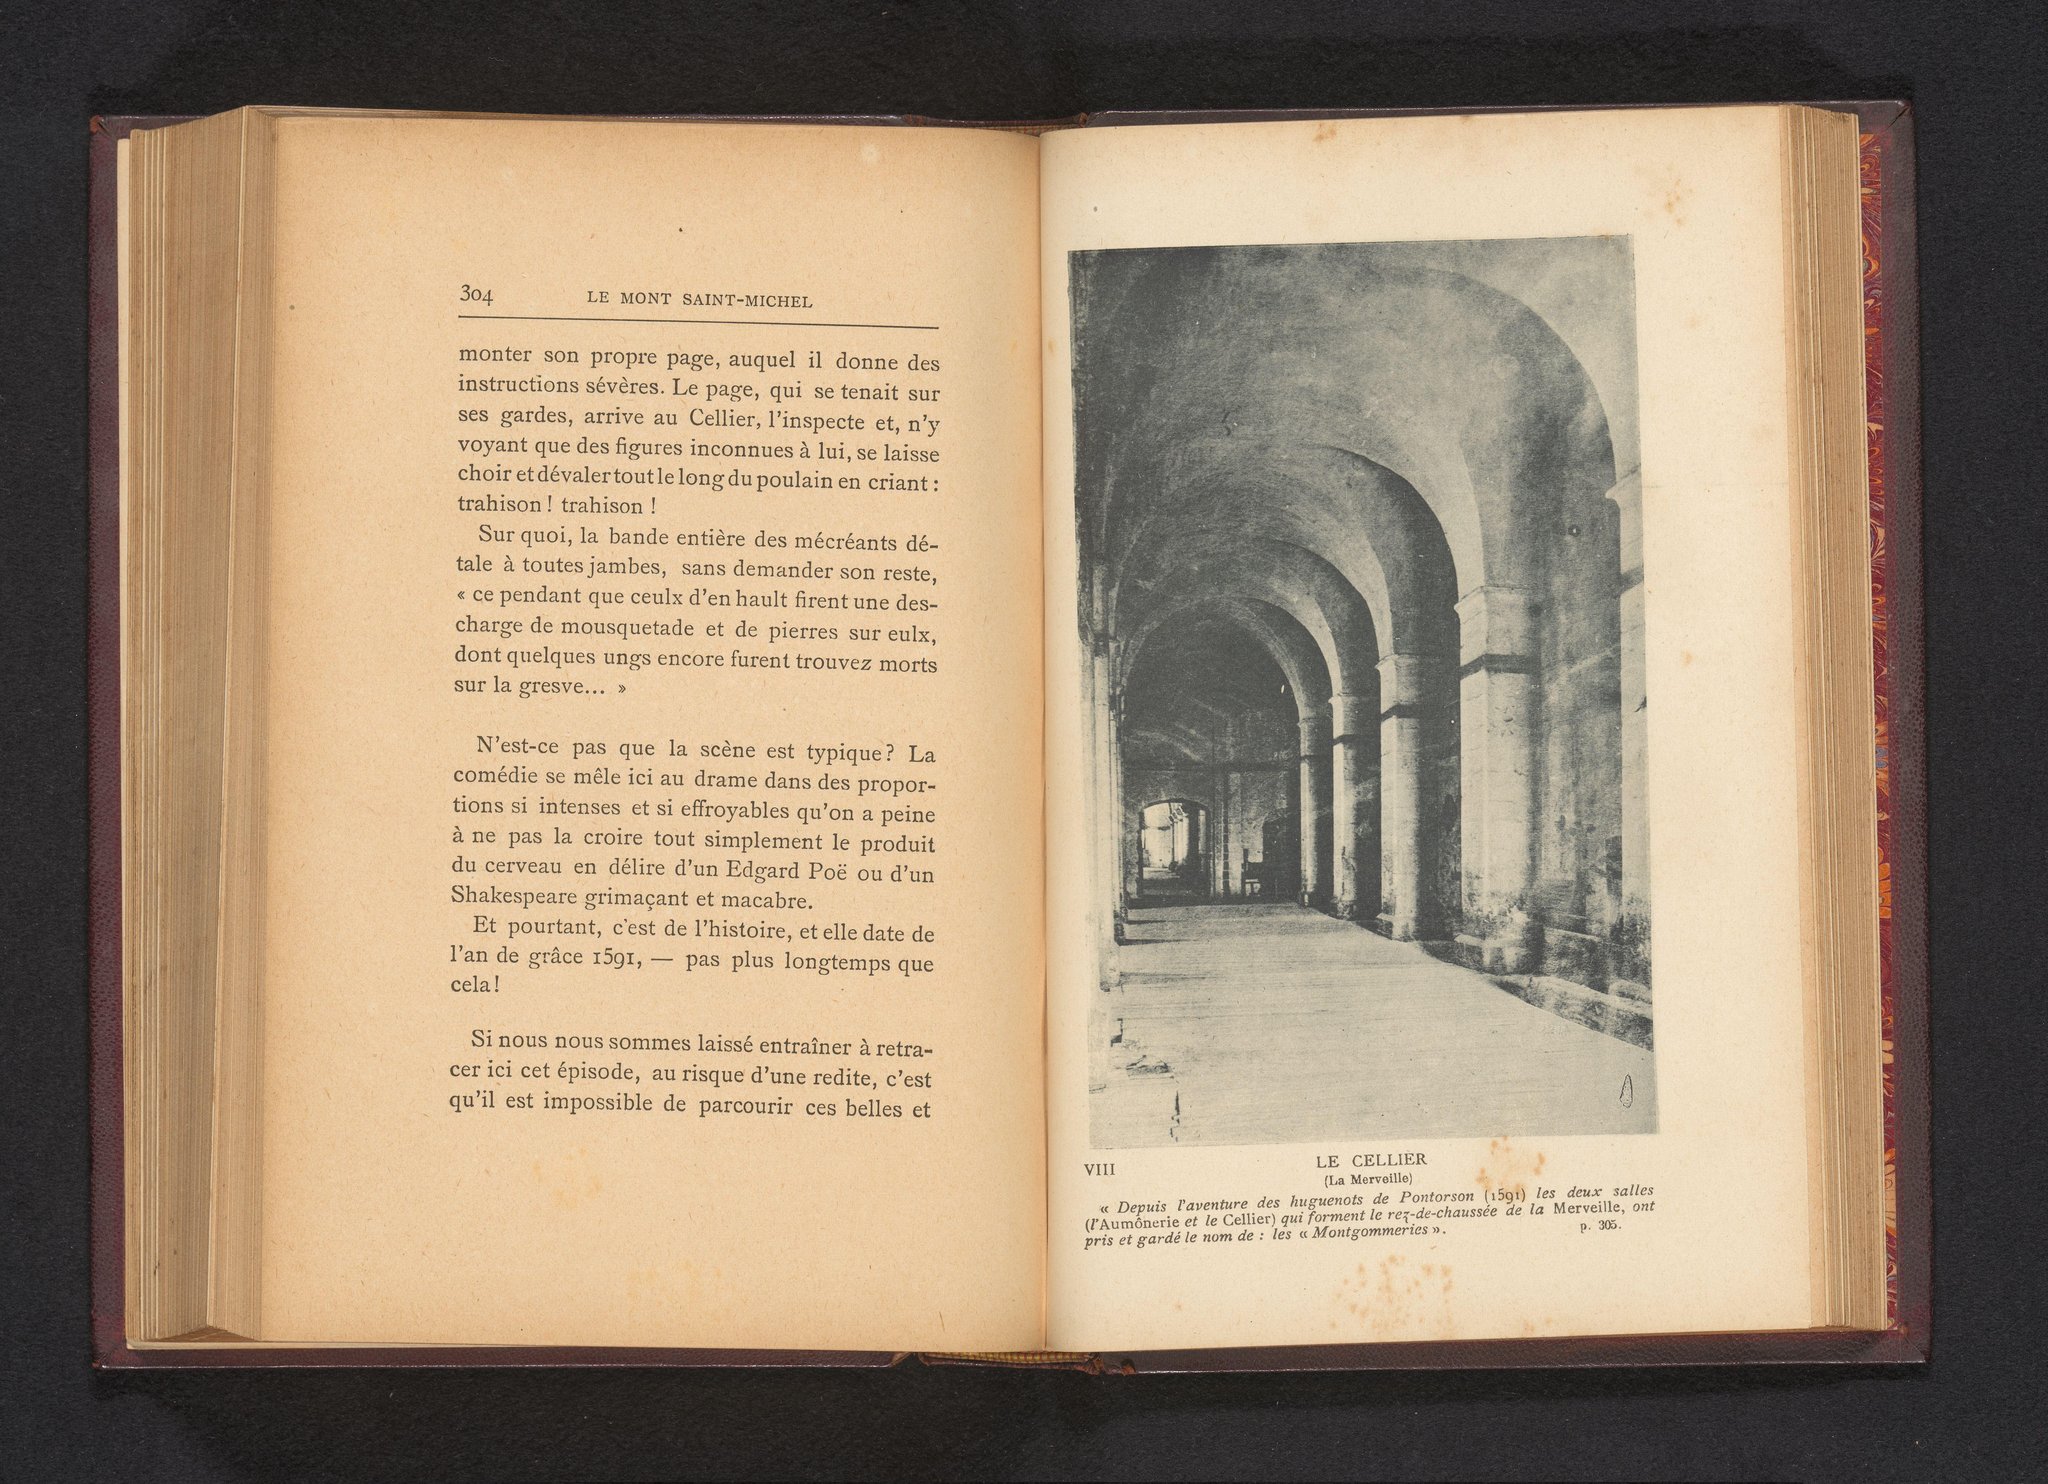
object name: page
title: Gezicht op de kelder van de abdij te Mont Saint-Michel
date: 1892-1897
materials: paper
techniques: photograph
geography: mont-saint-michel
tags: abbey, monastery, convent ~ roman catholic church, basement, cellar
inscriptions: inscription: ‘(La Merveille)/ Depuis l'aventure des huguenots de pontorson (1591) les deux salles (...)’, inscription: ‘VIII’